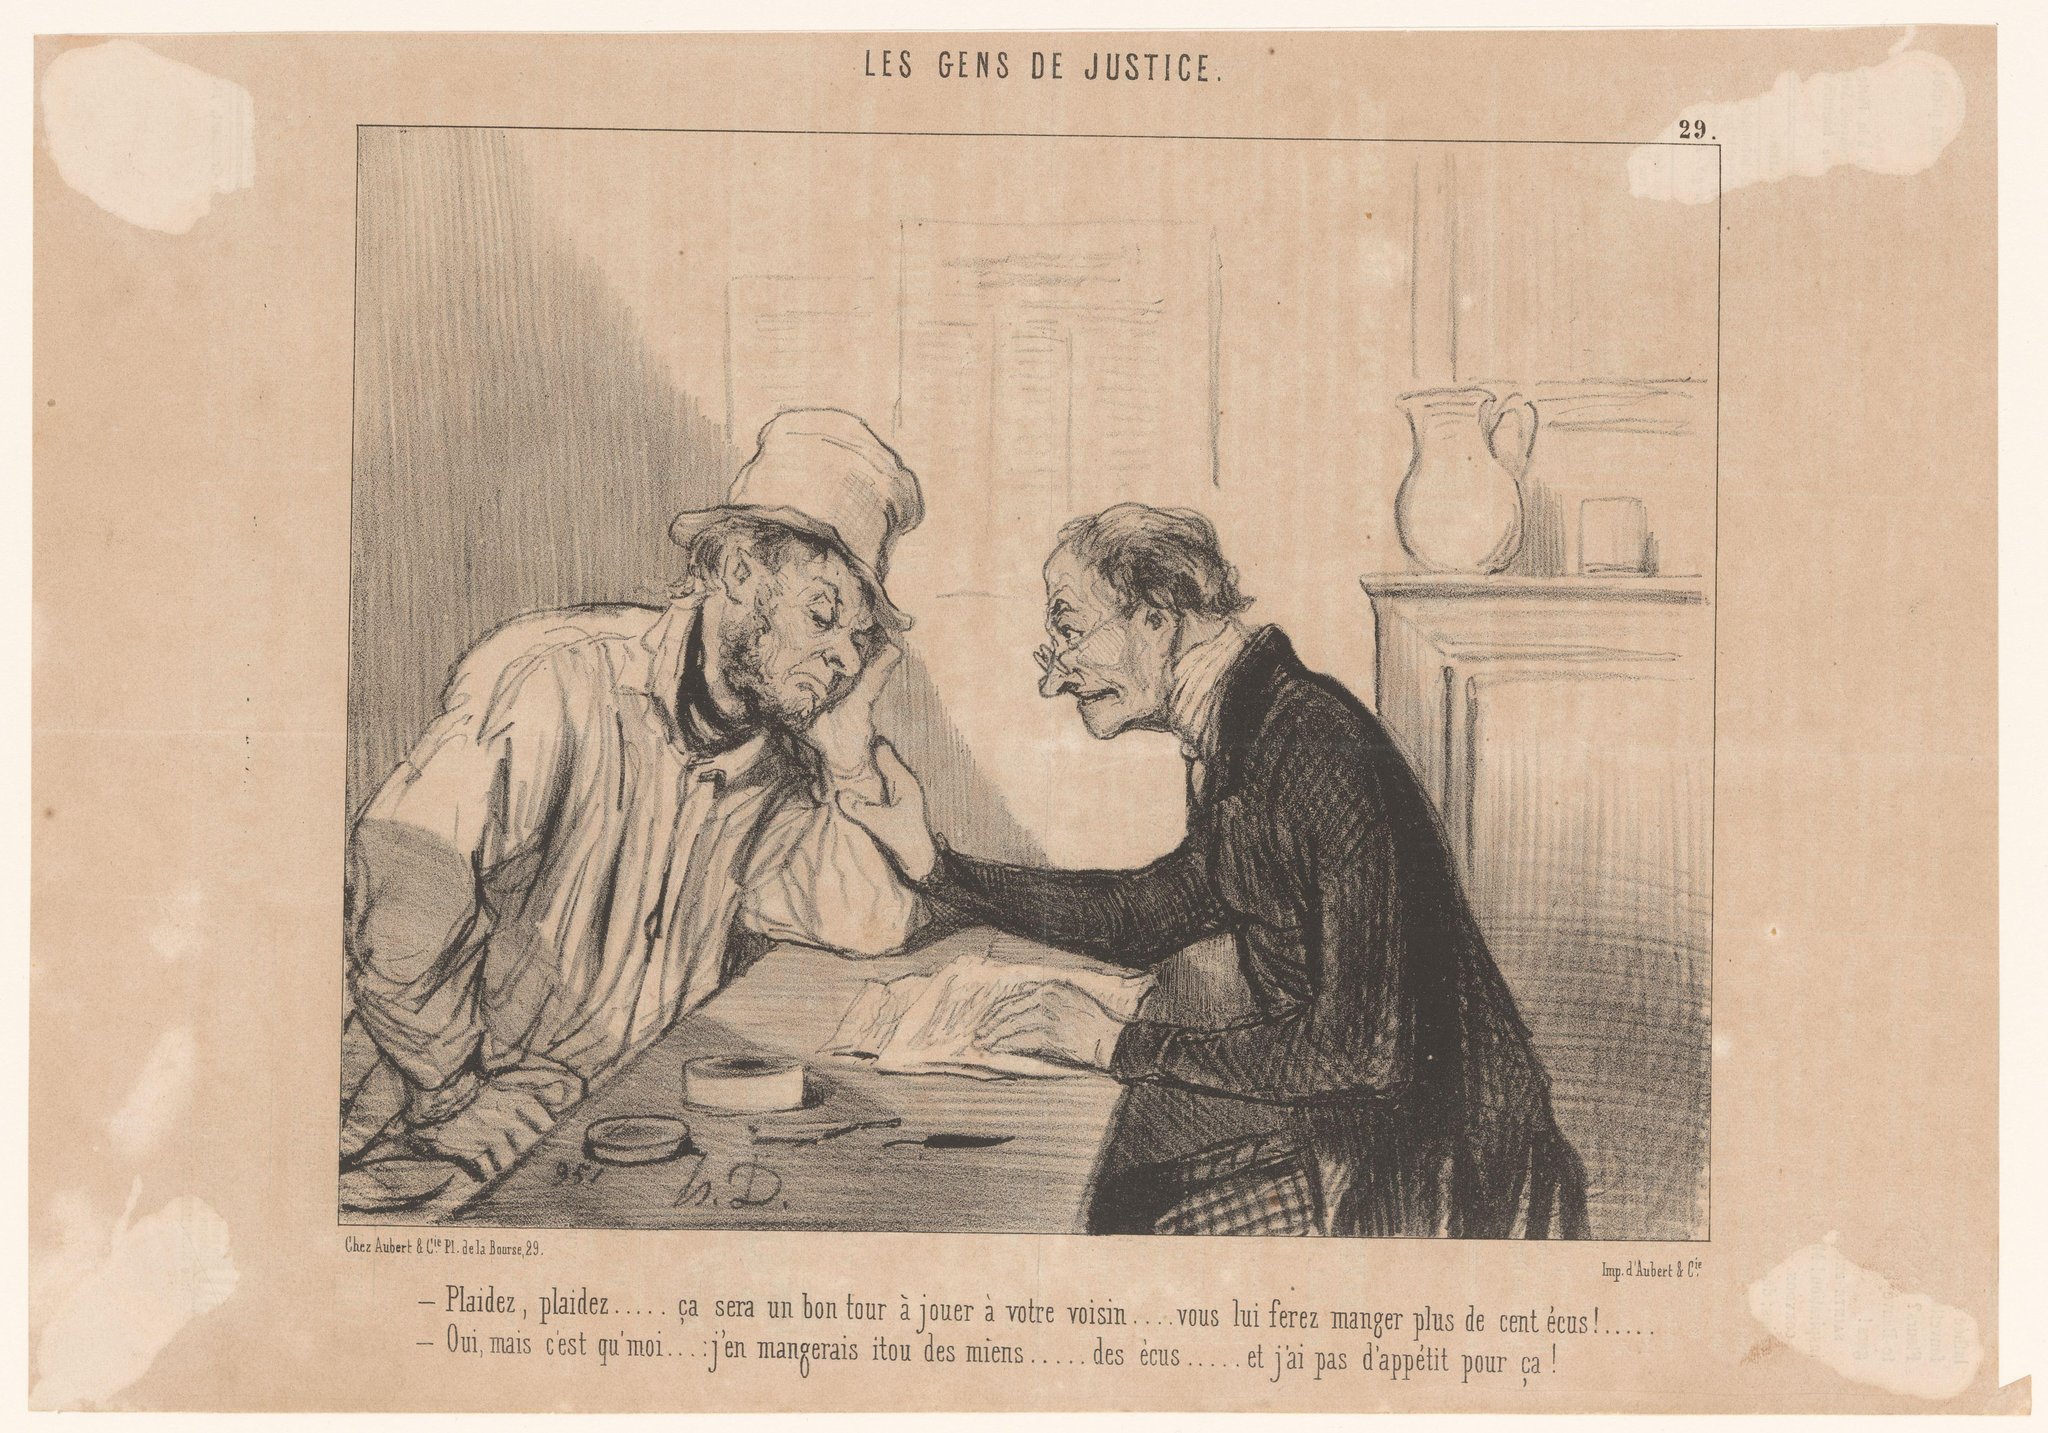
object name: cartoon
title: Les gens de justice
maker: honoré daumier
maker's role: draughtsman, painter, print maker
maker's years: 1808-1879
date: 1846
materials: paper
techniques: lithograph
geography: paris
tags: caricatures (human types), recommendation, inducement, incitement, law and jurisprudence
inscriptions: collector's mark: Lugt 2228a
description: Prent gebruikt voor: Le Charivari, 18-11-1846.